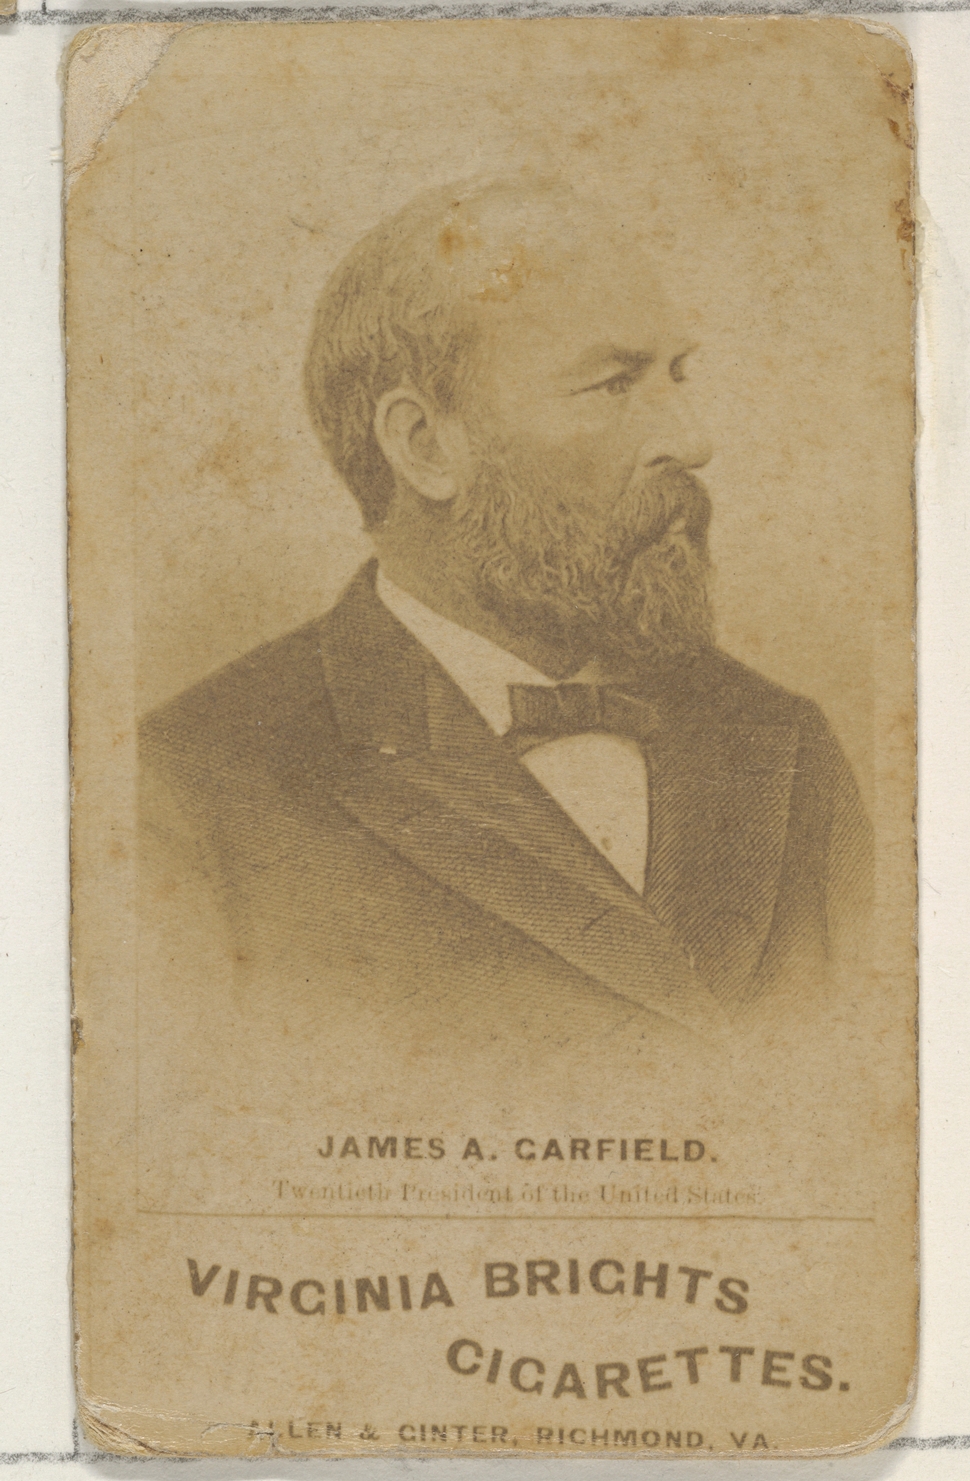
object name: photograph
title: James A. Garfield, from the Presidents of the United States series (N51) for Virginia Brights Cigarettes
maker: allen & ginter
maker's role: publisher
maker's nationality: american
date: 1885-1889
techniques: albumen silver print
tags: men